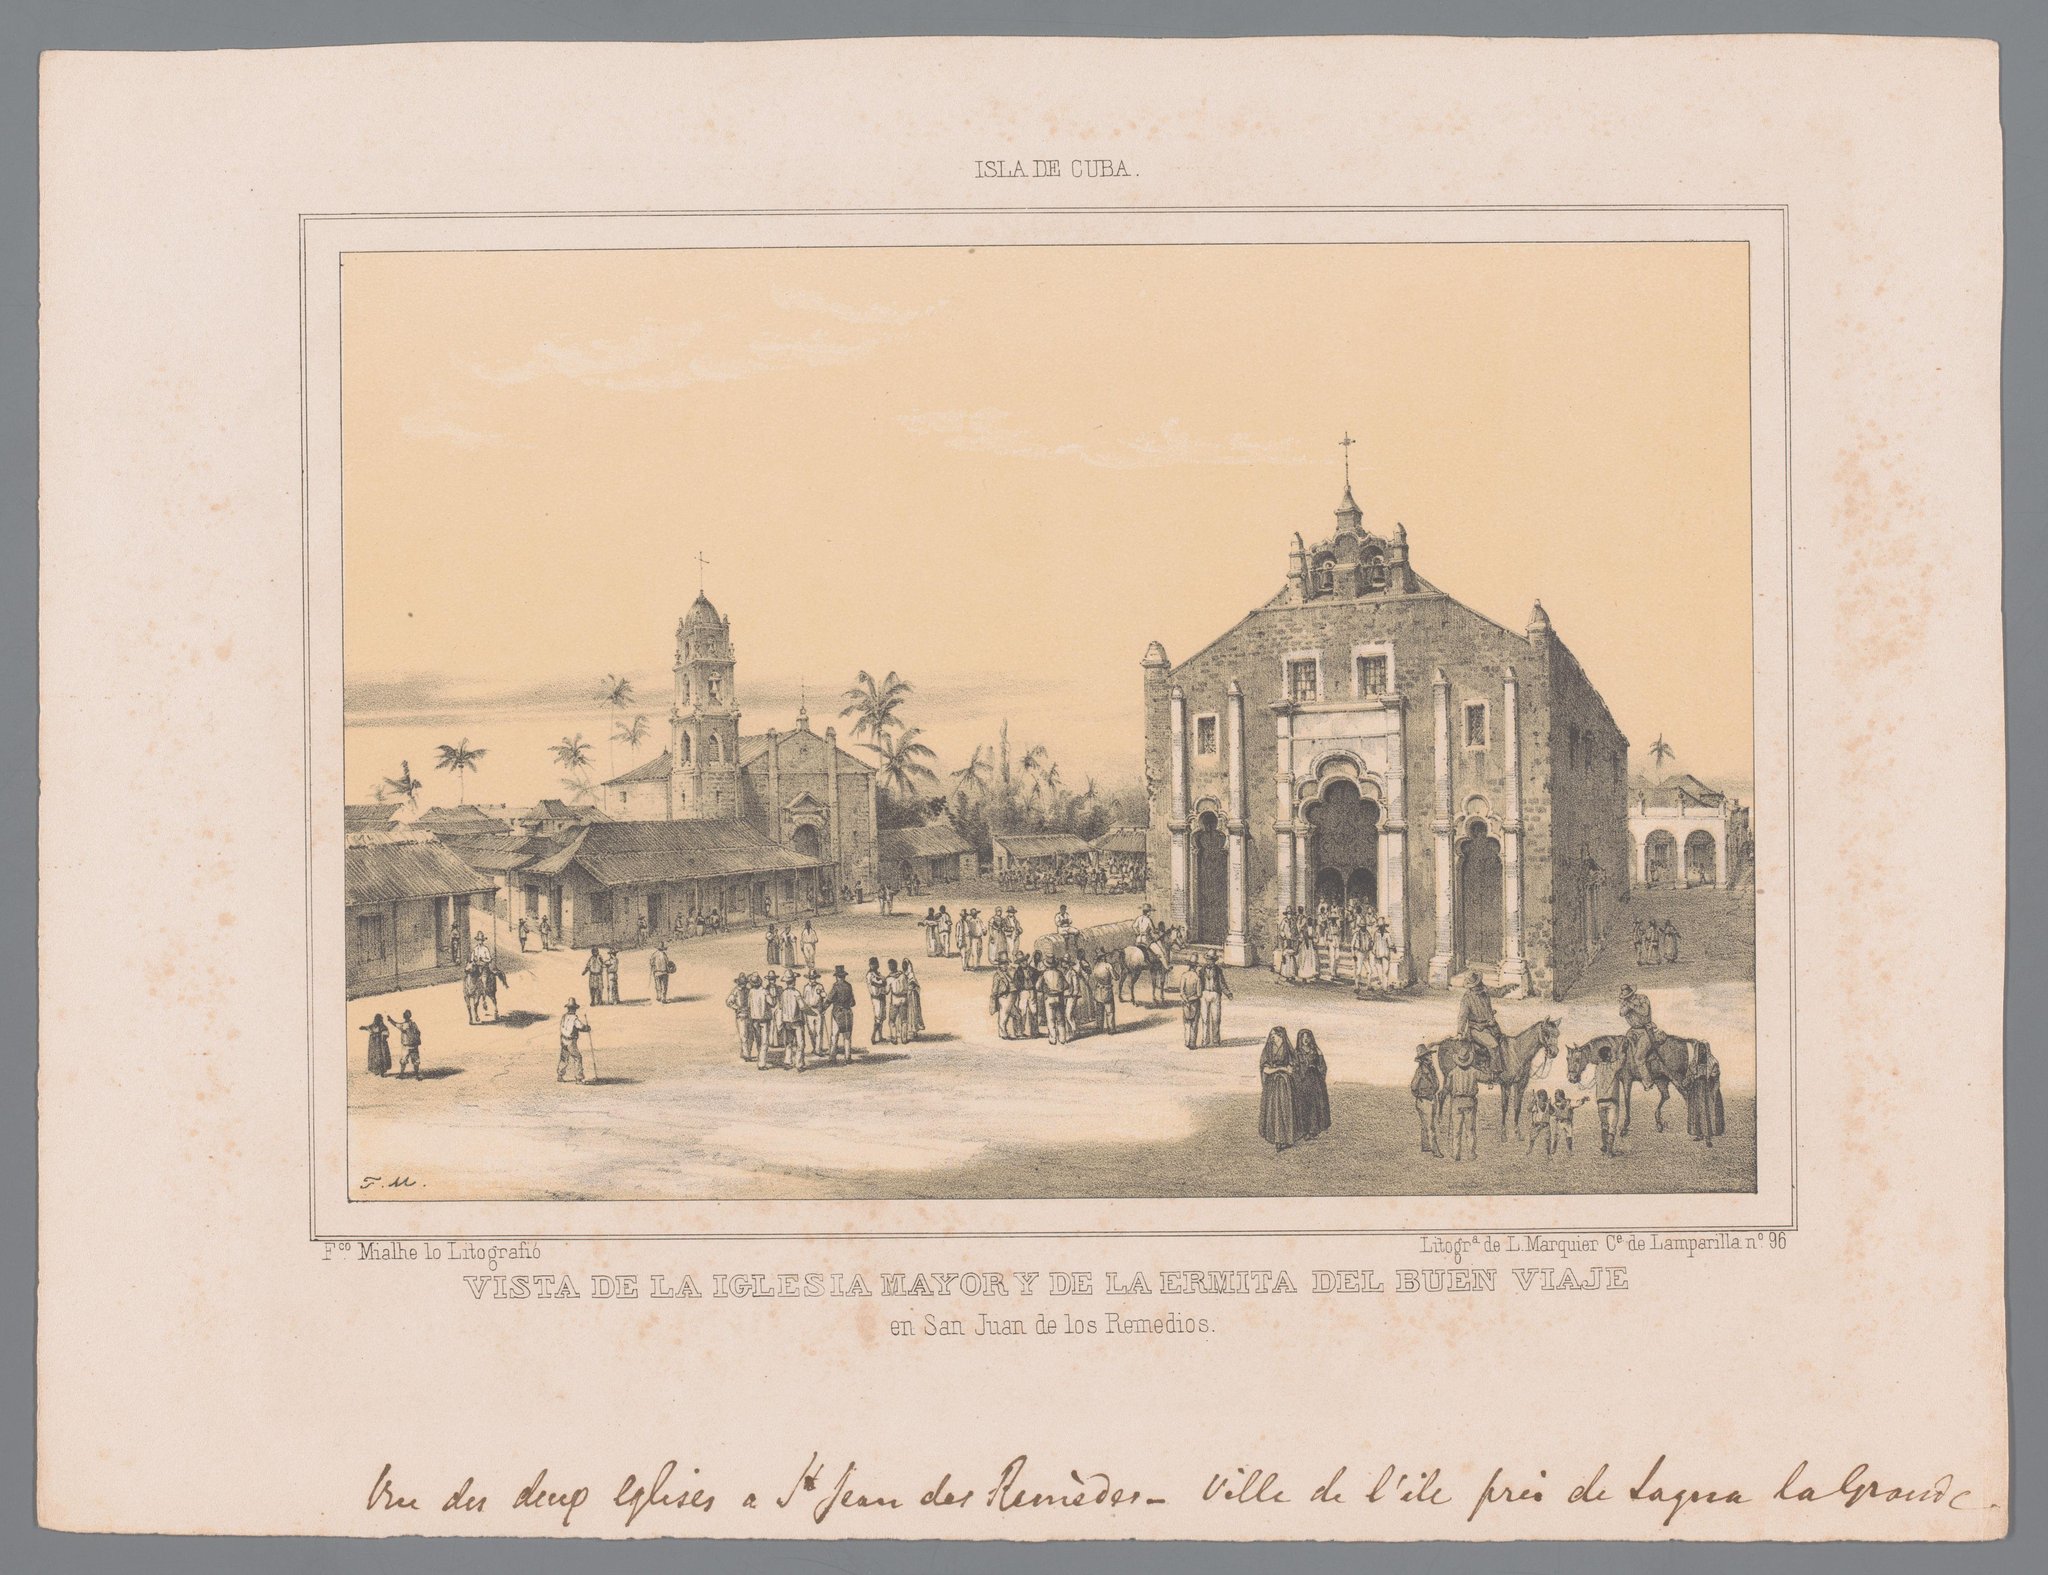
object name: print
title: Het eiland Cuba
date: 1848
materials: paper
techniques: tone lithography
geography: cuba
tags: church (exterior), village square, place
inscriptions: collector's mark: Lugt 2228